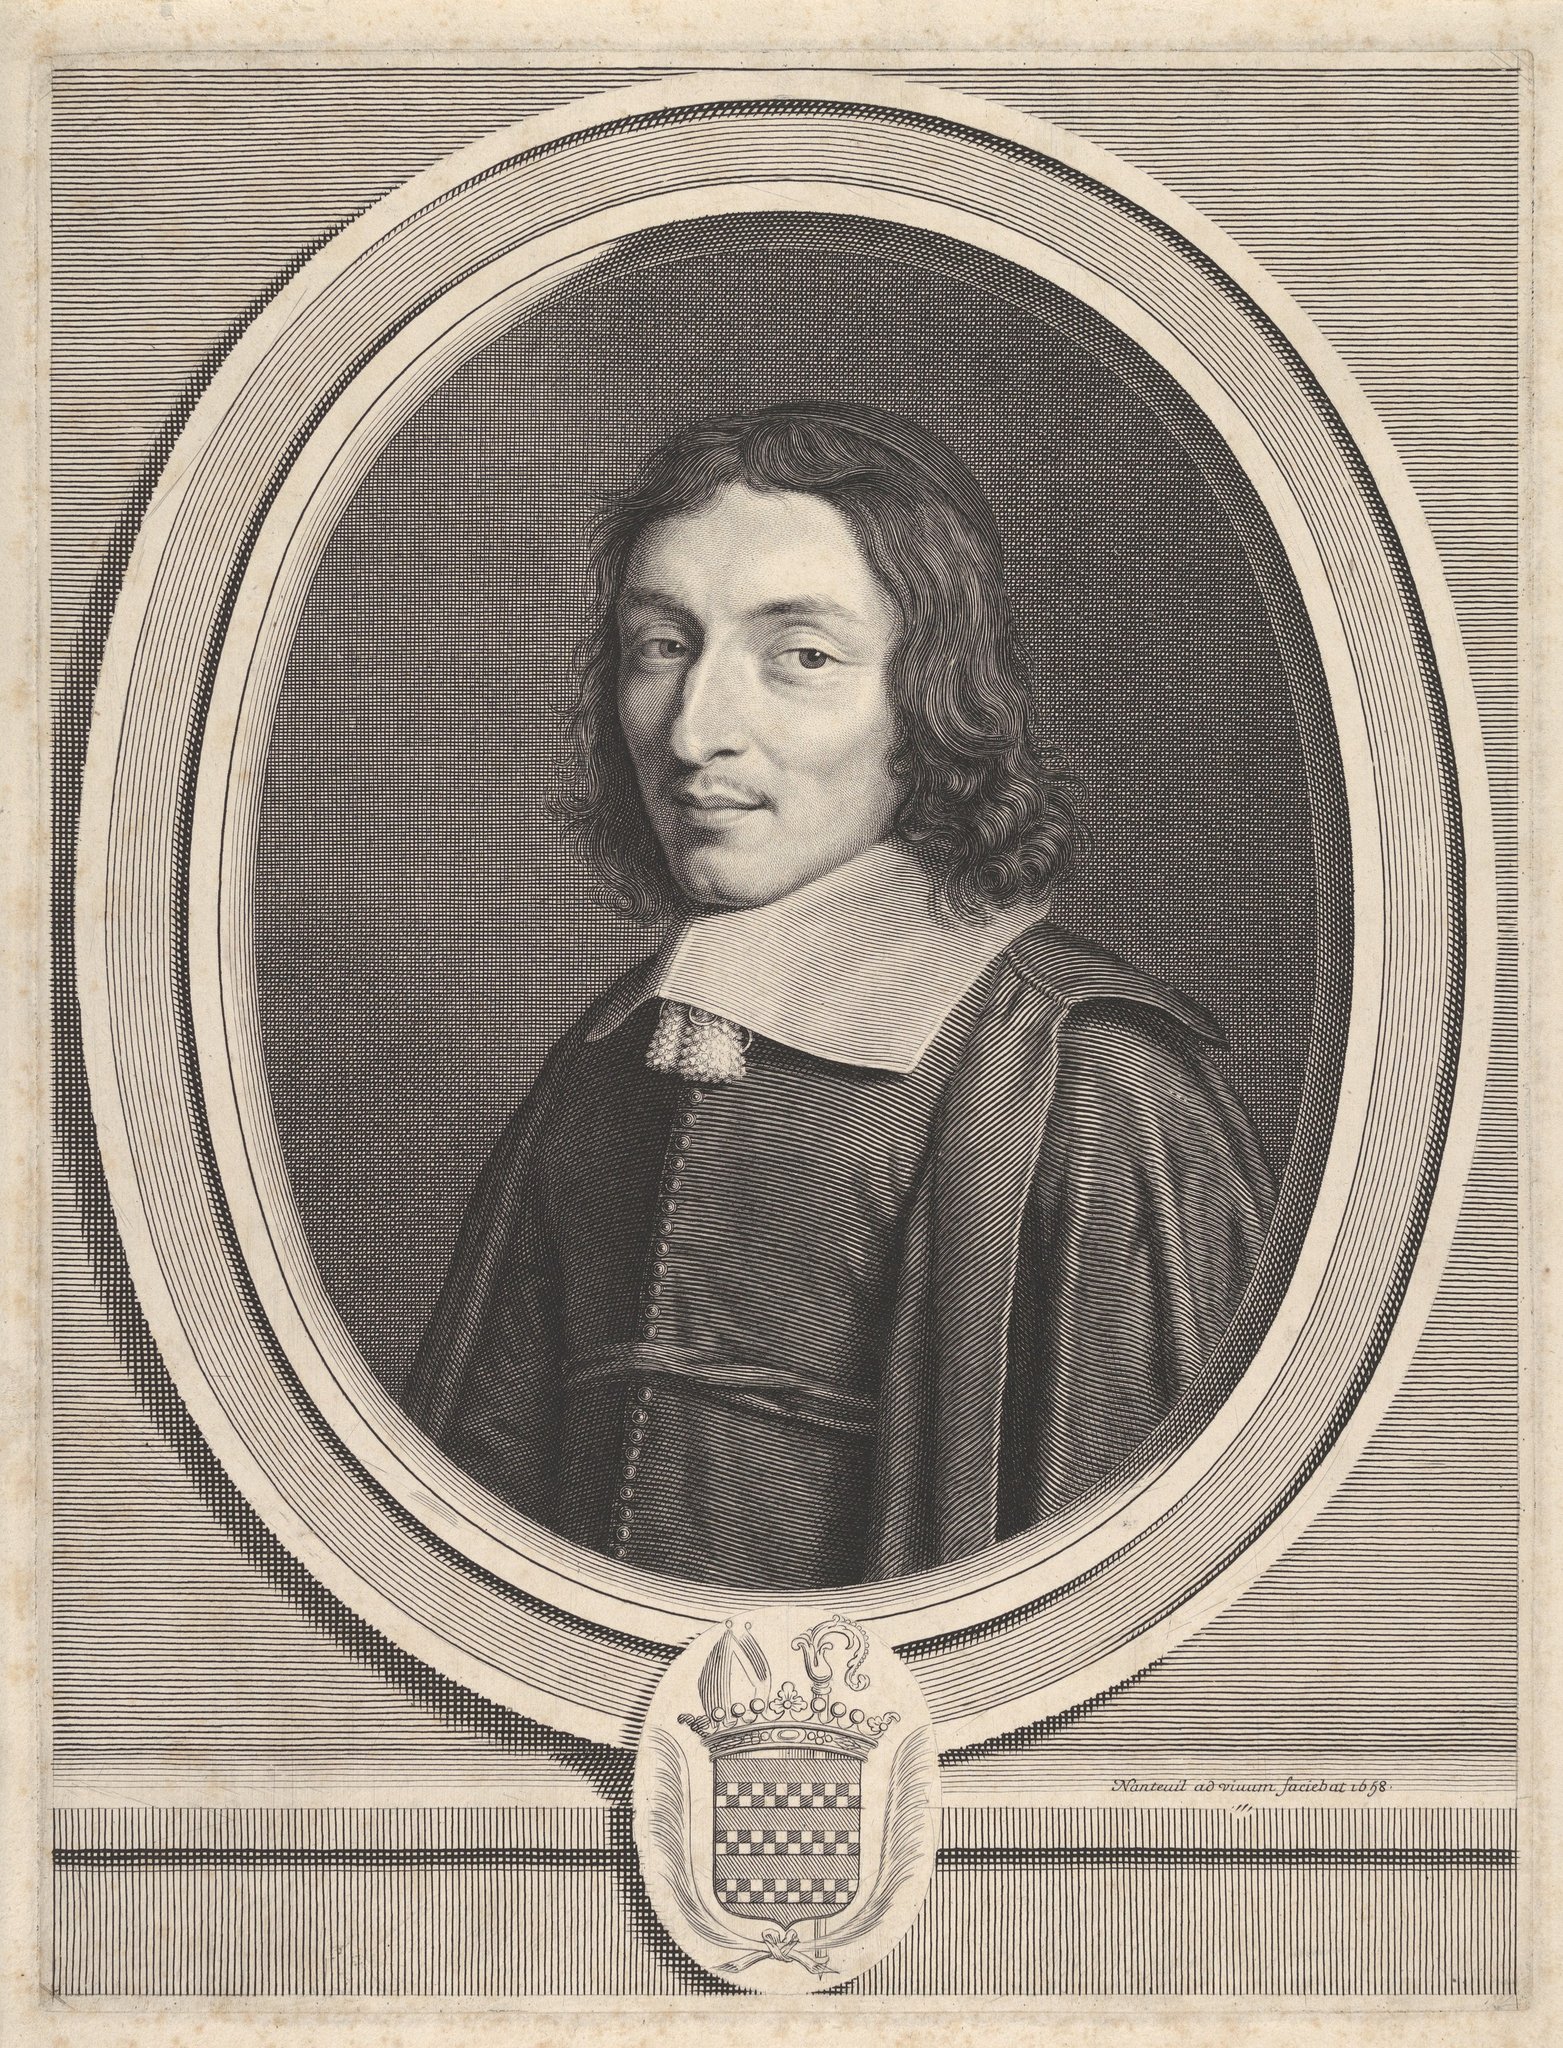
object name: print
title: Le Cardinal de Coislin (Pierre-Arnaud du Cambout de Coislin)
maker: robert nanteuil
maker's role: artist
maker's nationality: french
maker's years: 1623-1678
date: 1658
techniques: engraving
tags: men,portraits,coat of arms